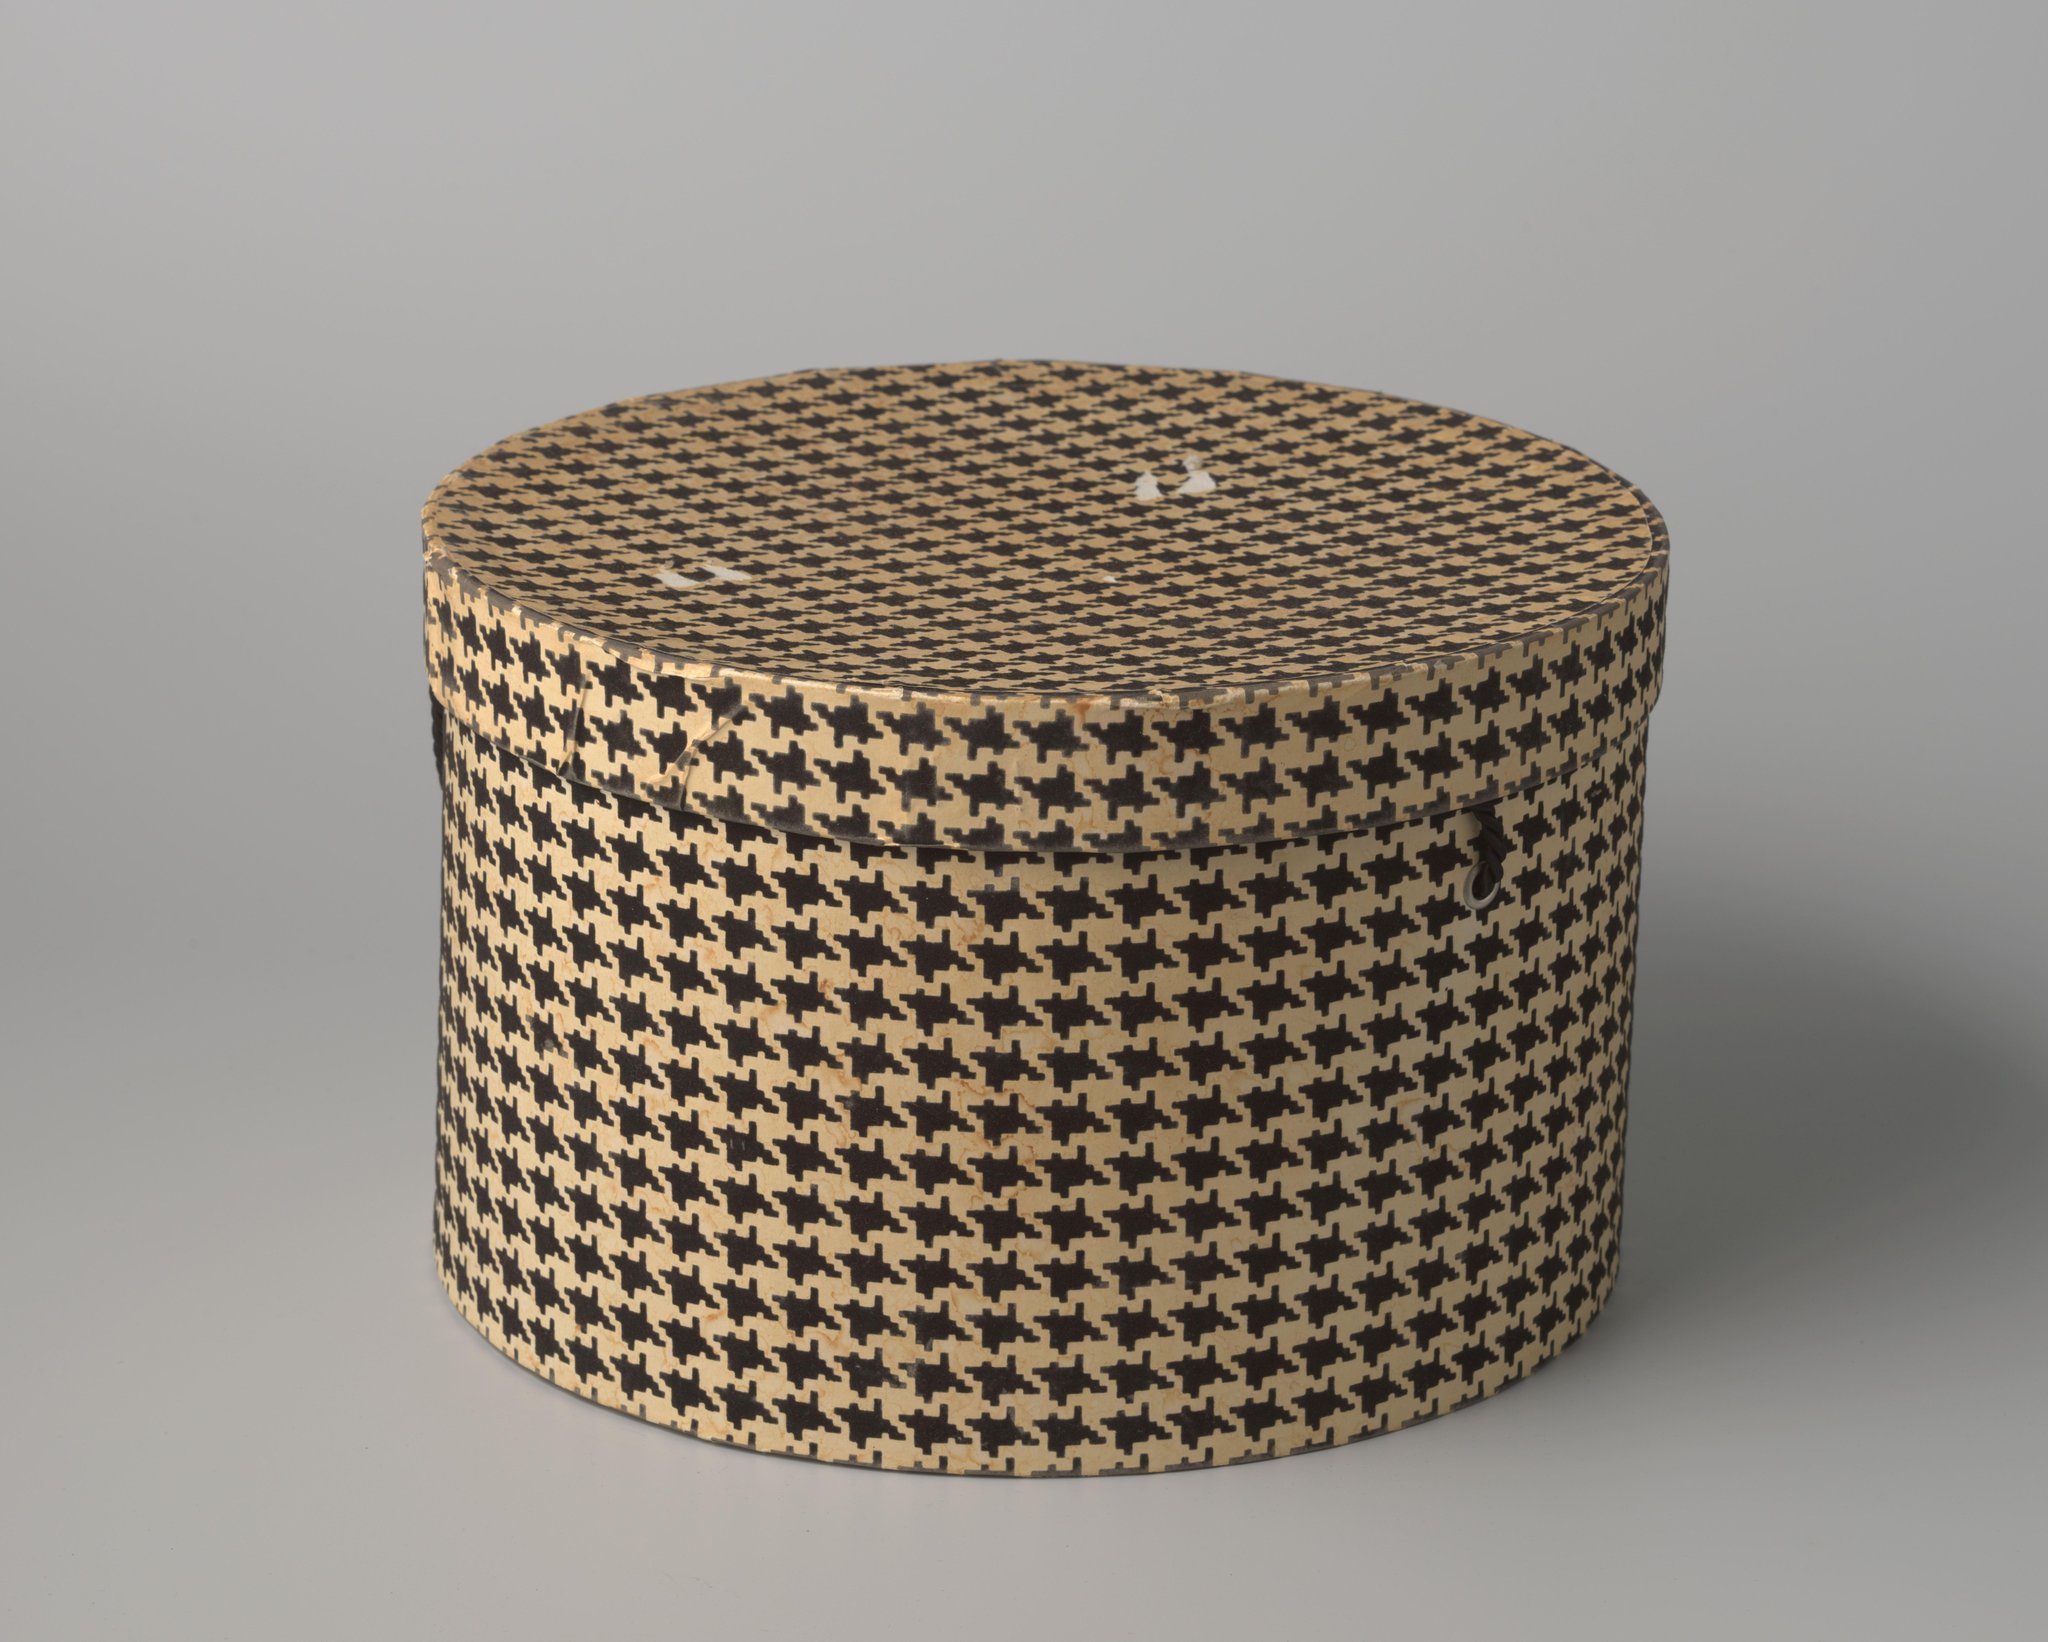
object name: hat box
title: Hoedendoos, rond, van karton beplakt met wit papier met pied-de-poule patroon in zwart fluweel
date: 1966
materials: cardboard, cotton, paper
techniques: stapling, twining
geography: zeist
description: Hoedendoos, rond, van karton beplakt met wit papier met pied-de-poule patroon in zwart fluweel. Met draagkoord van zwart katoen.